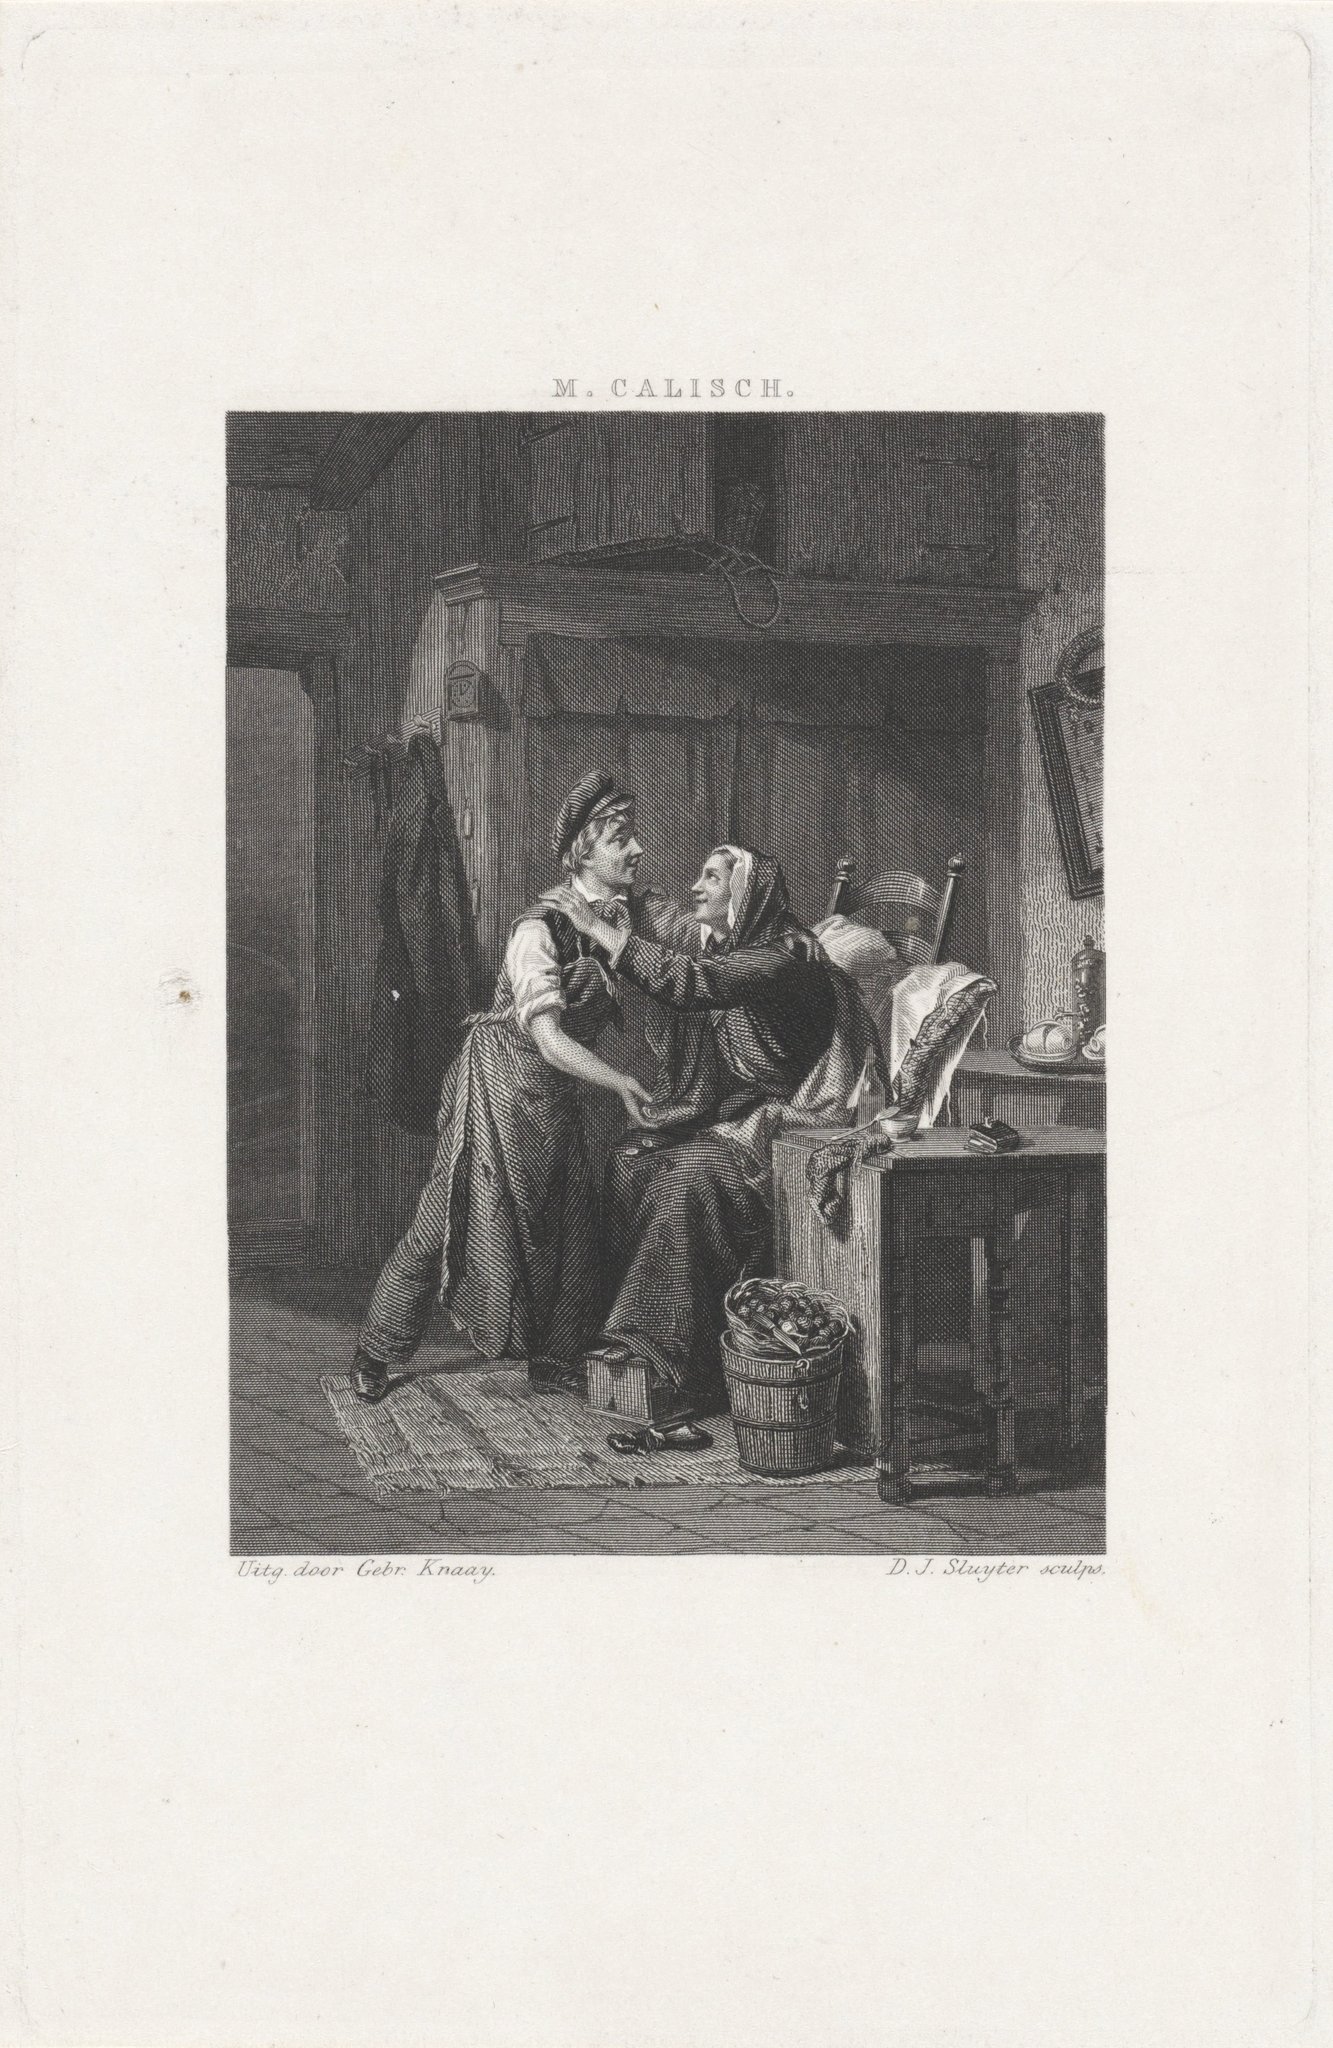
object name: print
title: Vrouw omarmt jongeman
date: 1867-1875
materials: paper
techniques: engraving, etching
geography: amsterdam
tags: coffee-pot, unequal couple, ill-matched couple, book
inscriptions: collector's mark: Lugt 2228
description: In een eenvoudig interieur zit een oudere vrouw op een stoel met haar voeten op een stoof en een kussen in de rug. Zij omarmt een jongeman met een pet op, die geld in haar schoot werpt. Op de tafel naast haar ligt een boek. Ernaast een kom met lepel. Op de grond een mand met knollen of aardappelen en een schilmesje.Achter haar op een tafeltje een koffiestel met kopjes.